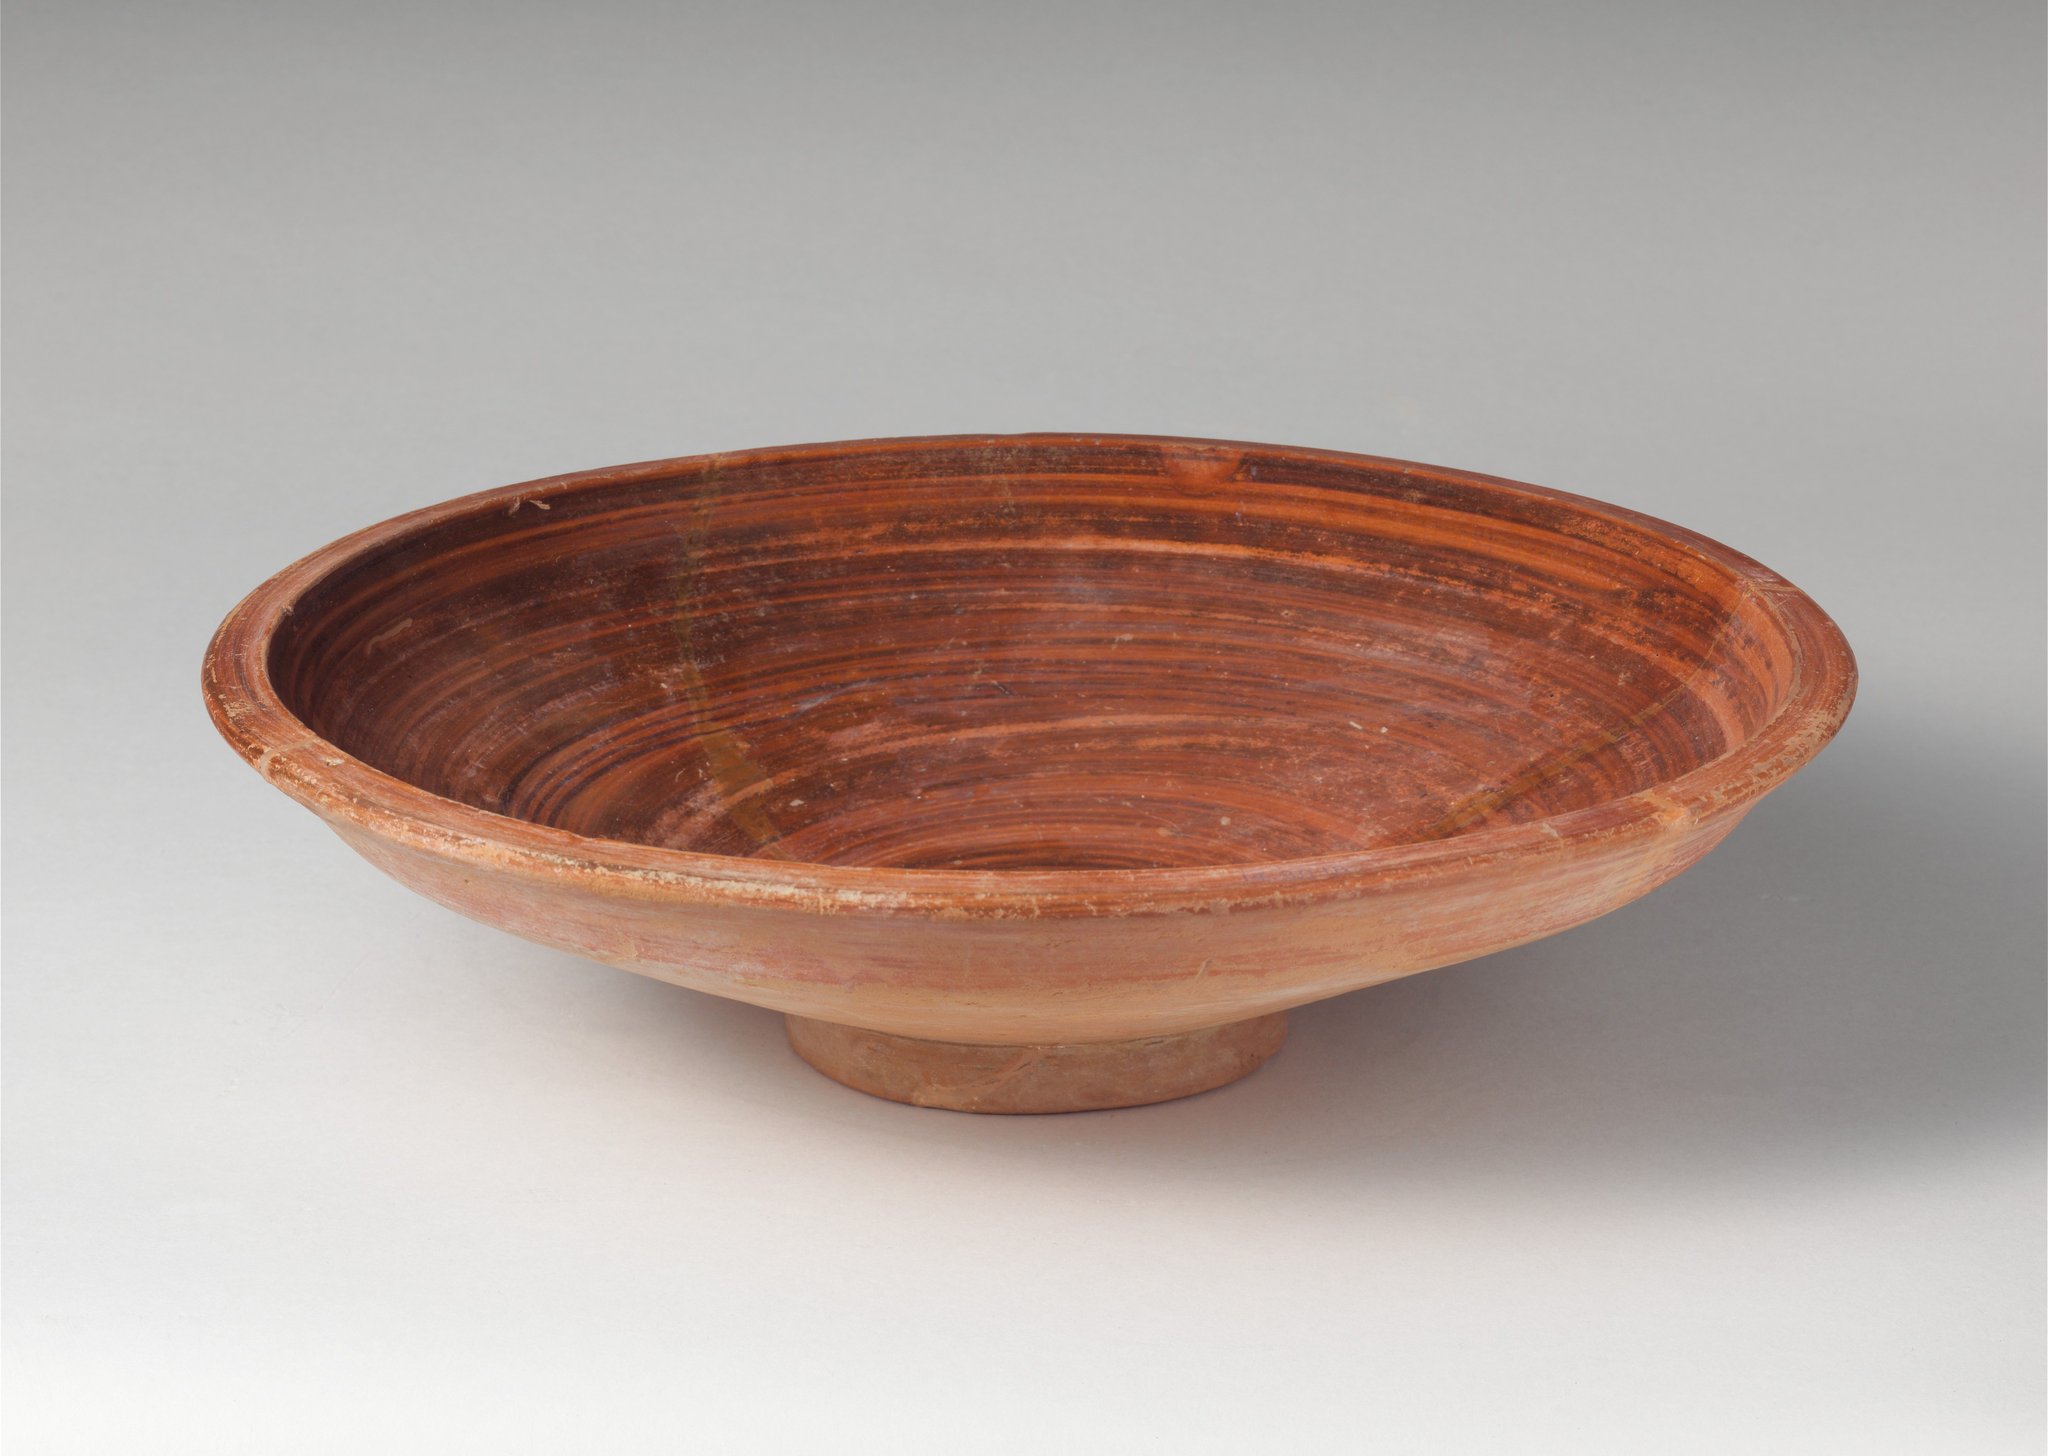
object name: bowl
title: Terracotta footed bowl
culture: lydian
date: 600-568 BCE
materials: terracotta